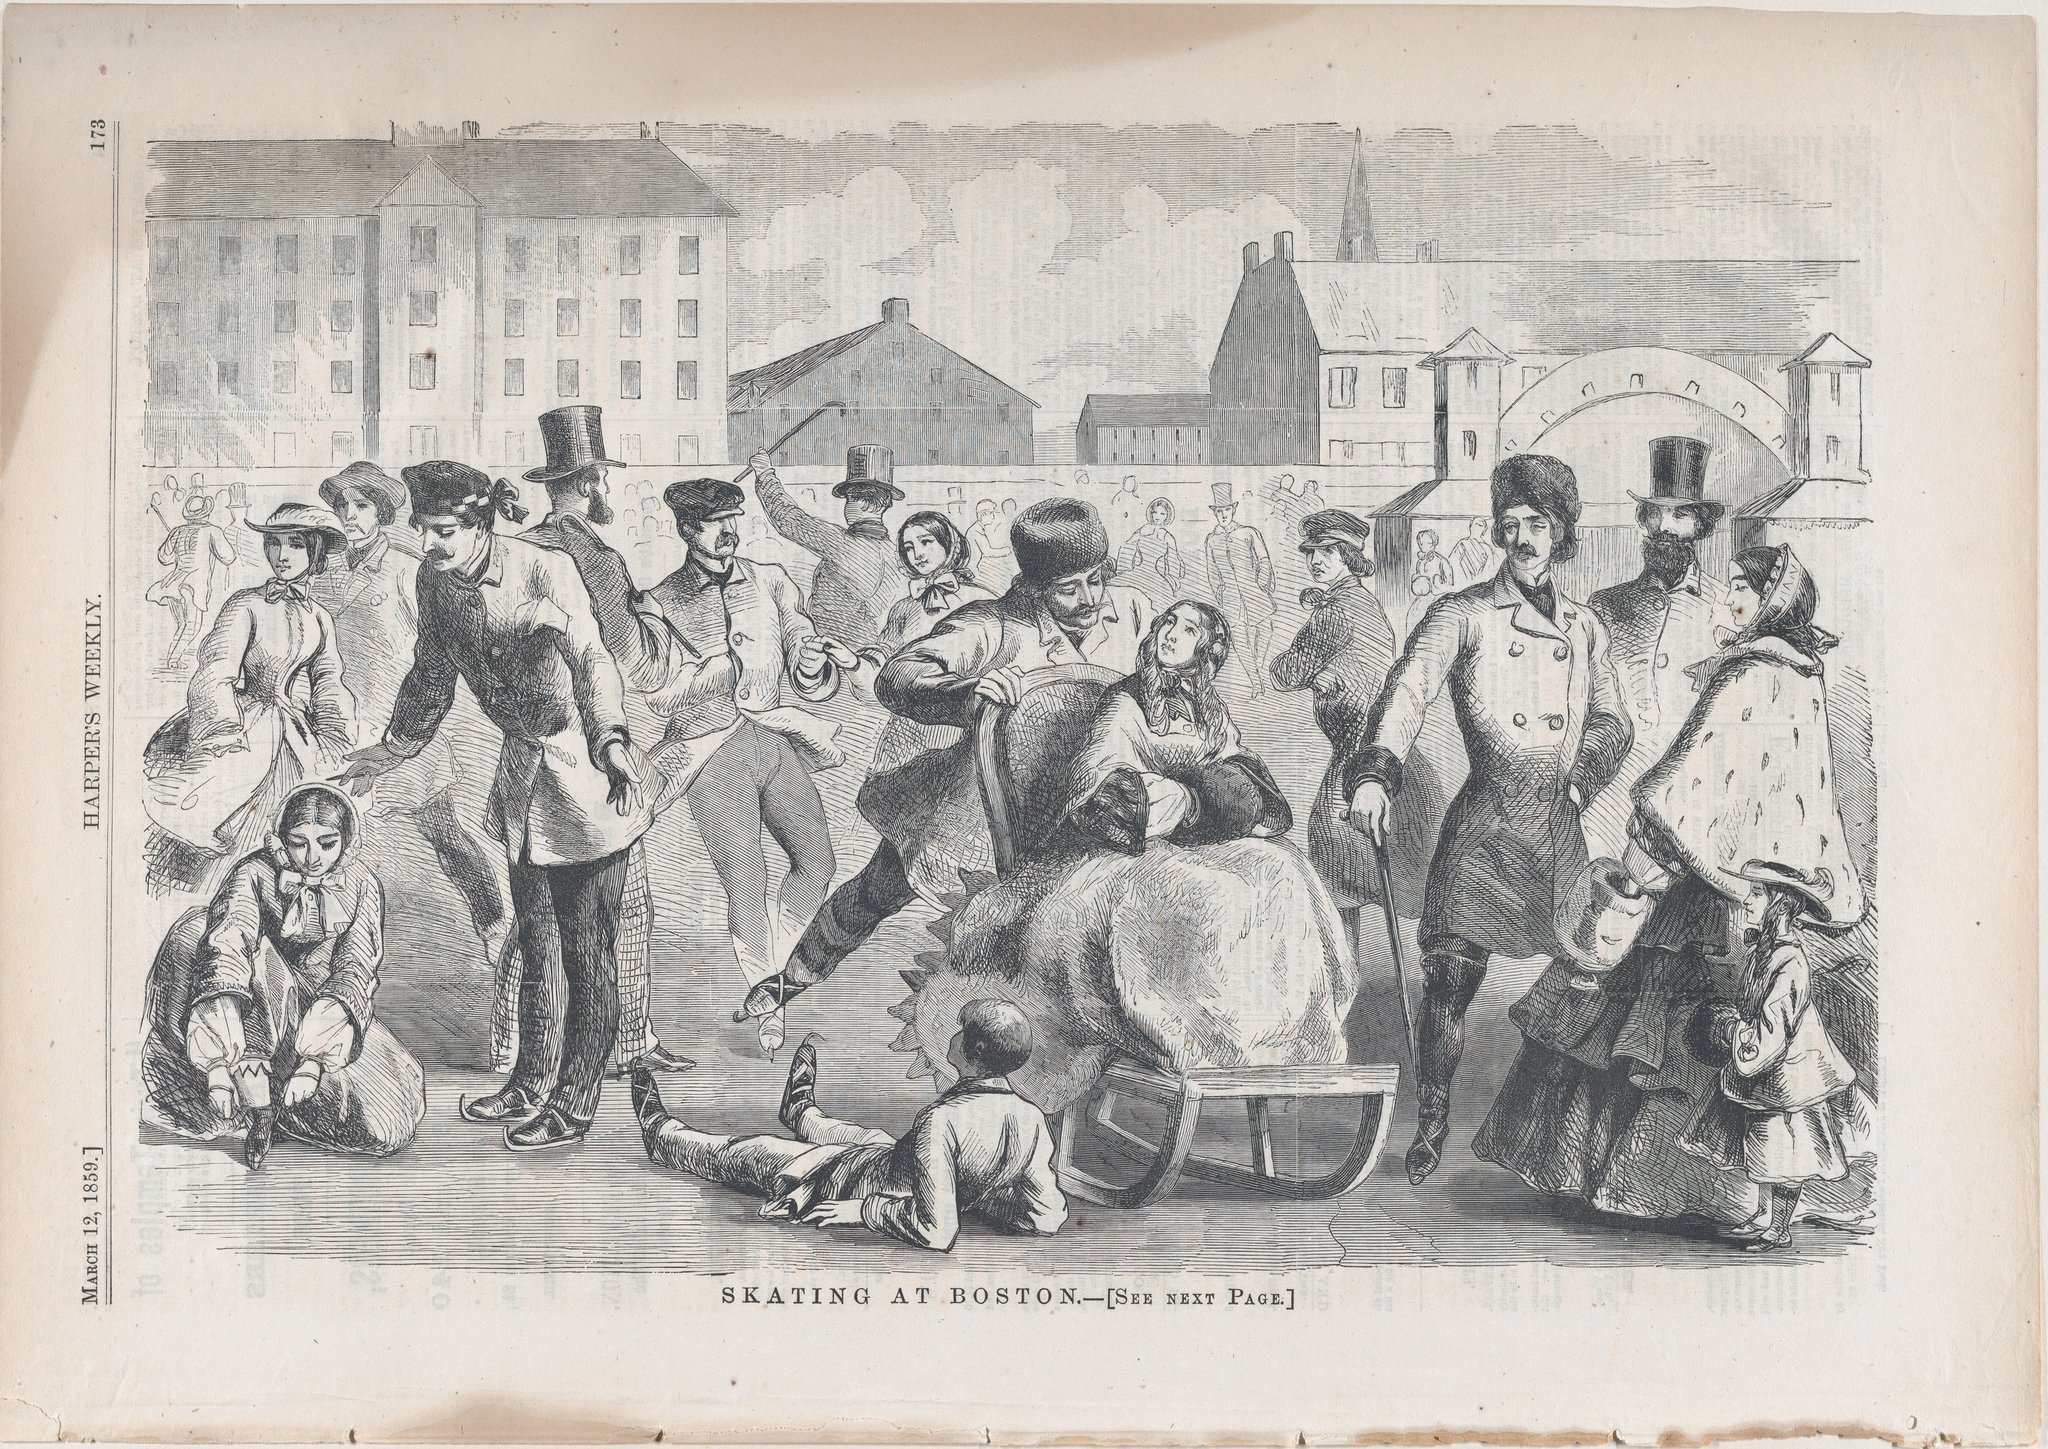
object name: print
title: Skating at Boston (from "Harper's Weekly," Vol. III)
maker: winslow homer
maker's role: artist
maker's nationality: american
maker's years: 1836-1910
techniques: engraving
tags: men,women,skating